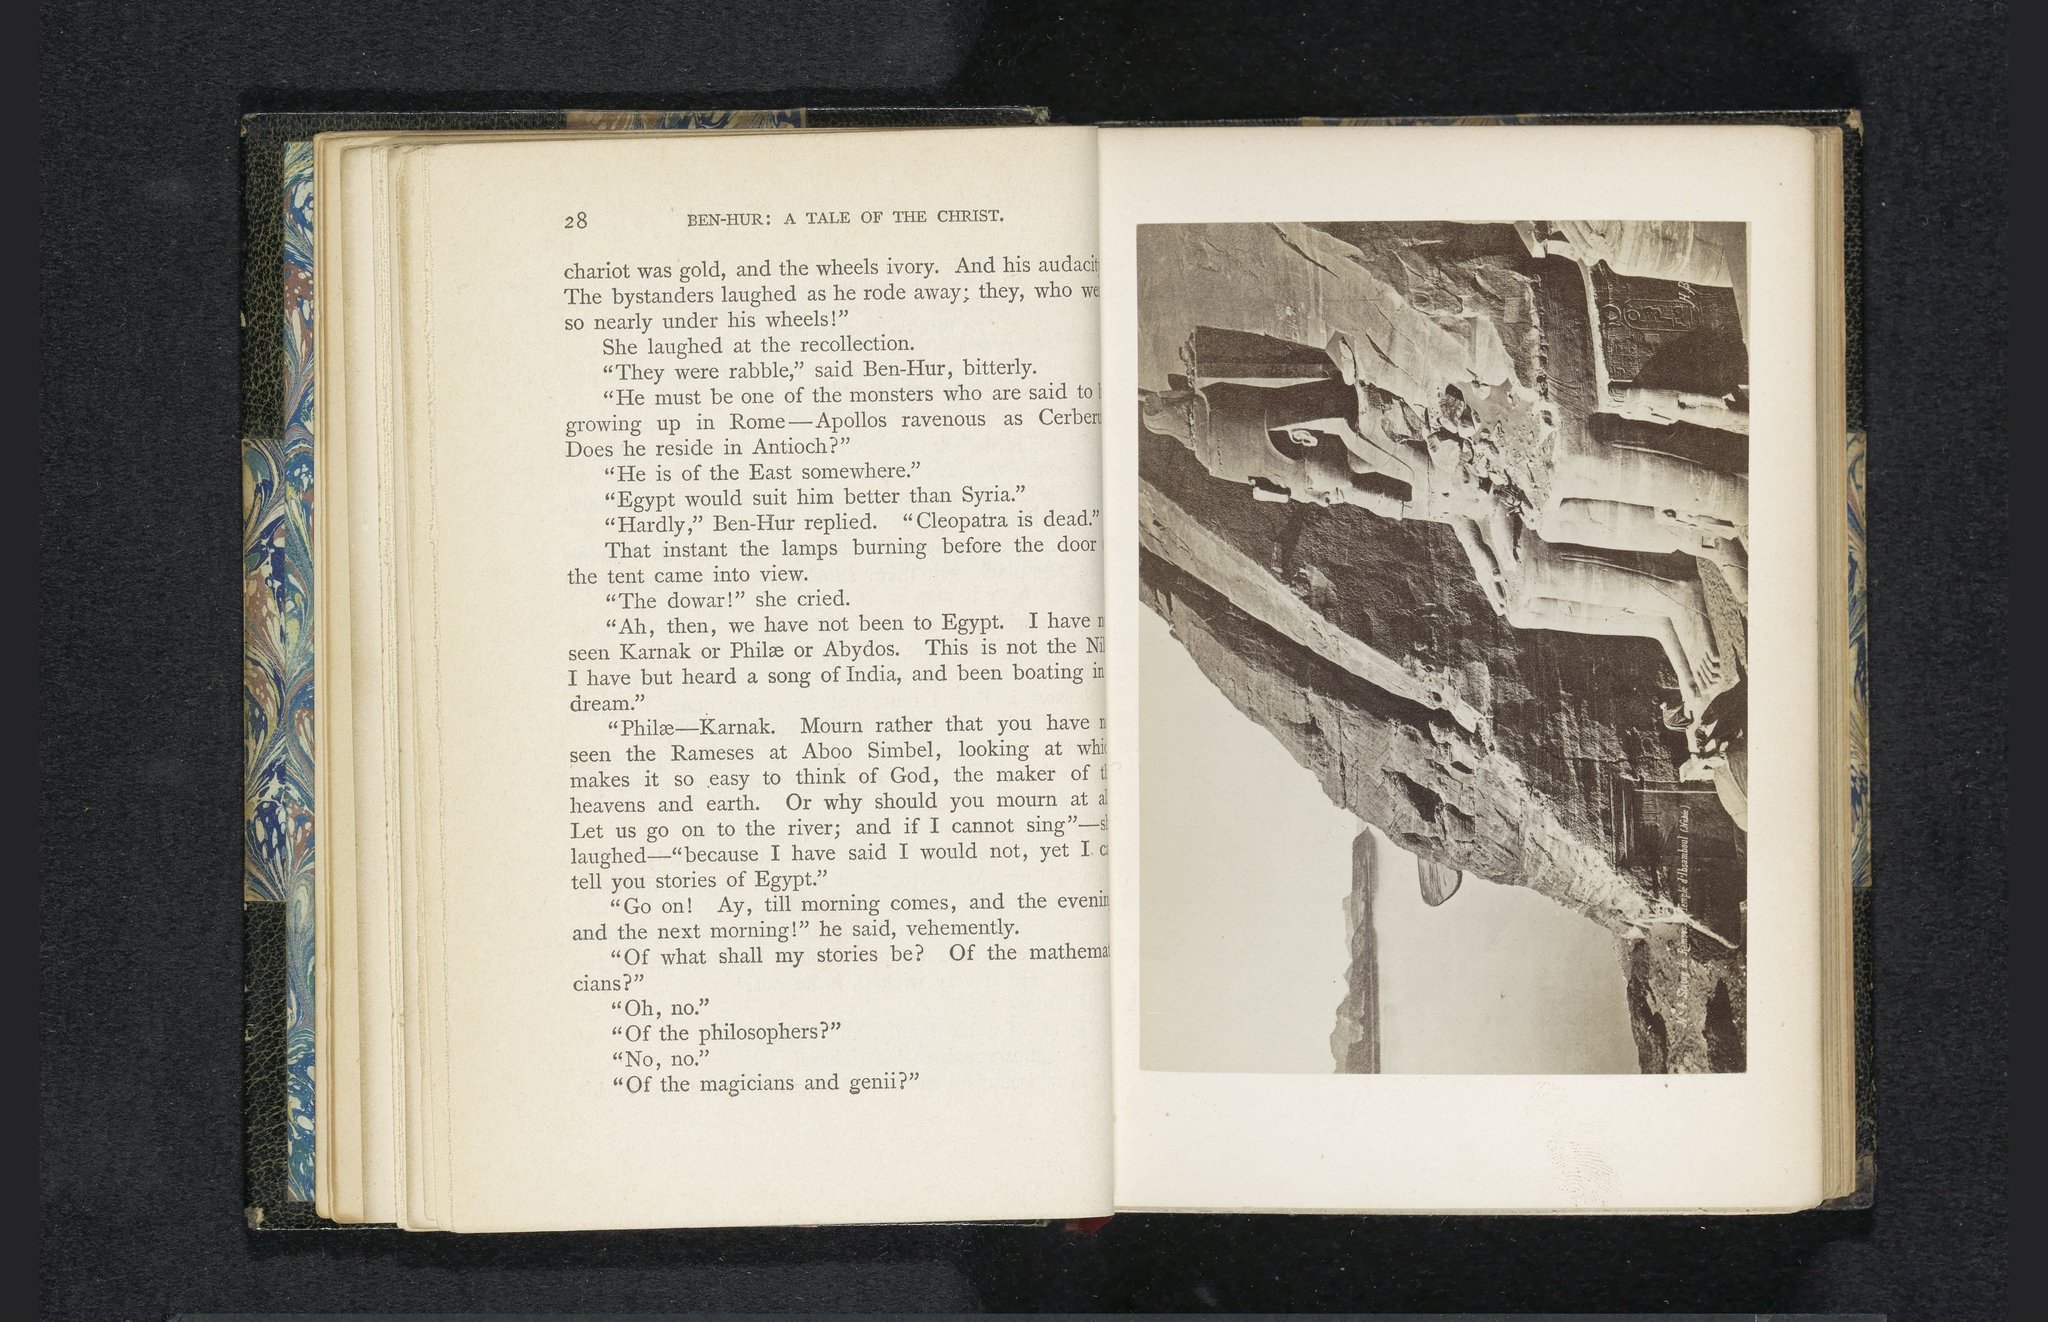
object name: page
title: Standbeeld van farao Ramses II voor de tempel van Aboe Simbel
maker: henri béchard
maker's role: fotograaf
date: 1883-1888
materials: photographic support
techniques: albumen print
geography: abu simbel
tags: temple, shrine ~ egyptian religion, sculpture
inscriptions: number: ‘No 4’